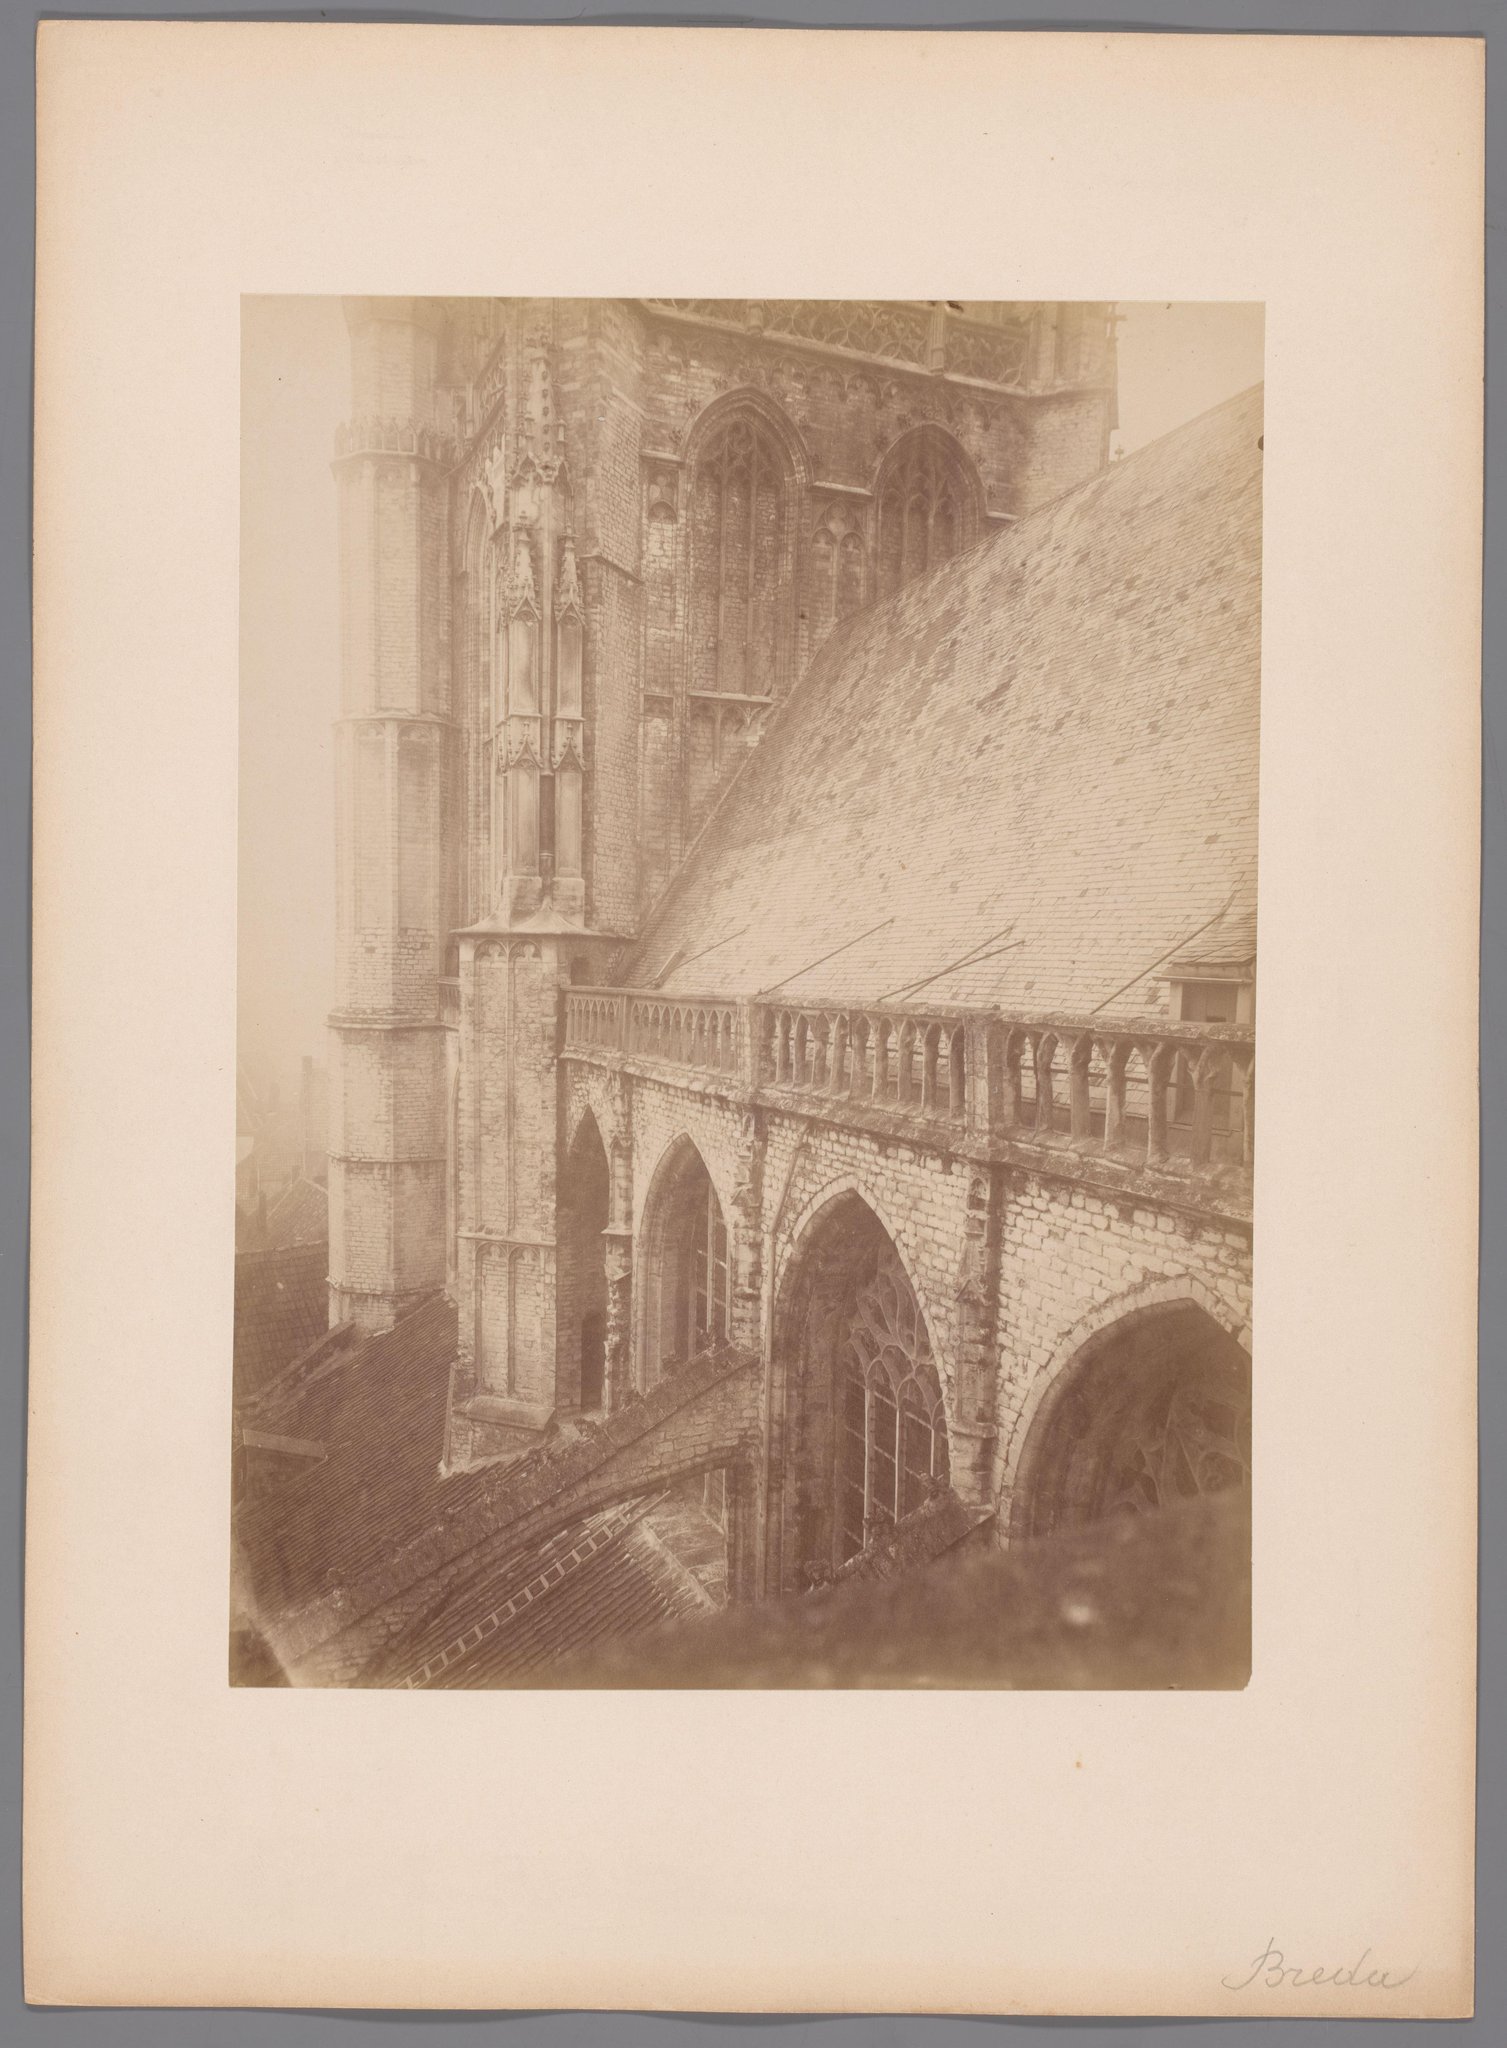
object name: photograph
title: Grote Kerk te Breda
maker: anoniem (monumentenzorg)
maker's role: fotograaf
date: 1890-1920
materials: cardboard, photographic support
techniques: albumen print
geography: breda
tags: parts of church exterior and annexes: tower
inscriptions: annotation: ‘Gedeelte v/d toren v/d Ned. Herv. Kerk te Breda’, annotation: ‘Breda’